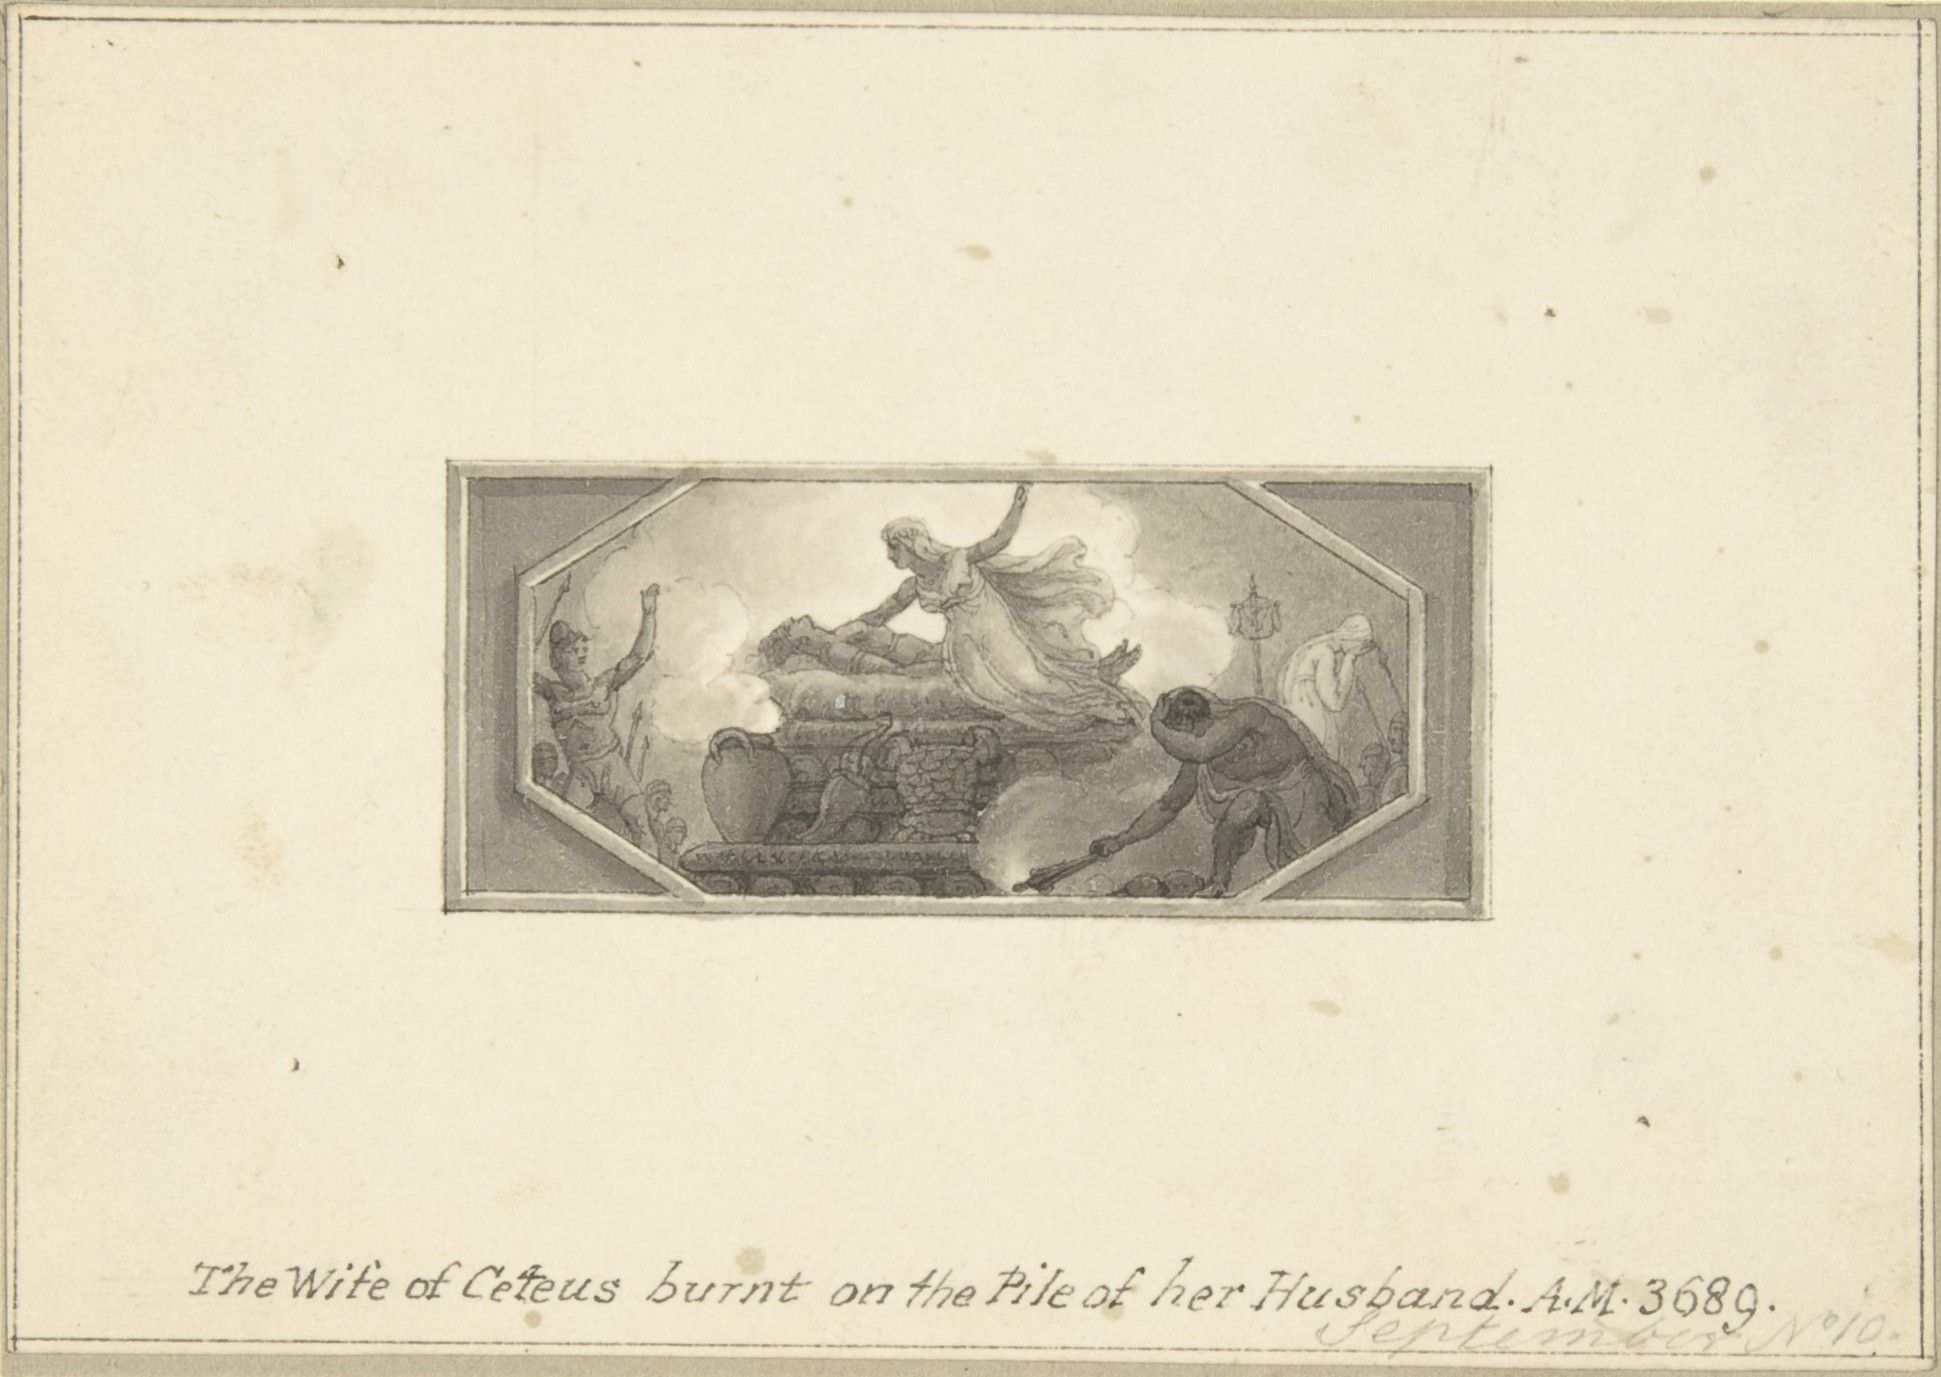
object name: drawing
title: The Wife of Ceteus burnt on the Pile of her Husband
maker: edward francis burney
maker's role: artist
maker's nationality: british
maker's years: 1760-1848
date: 1790-1800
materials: ink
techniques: brush, pen, wash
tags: men,women,fire,death